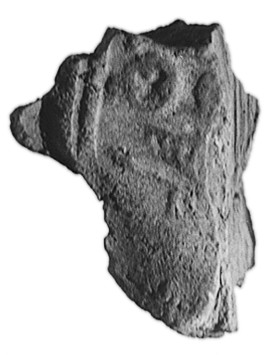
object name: sealing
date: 2030-1640 BCE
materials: clay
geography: egypt